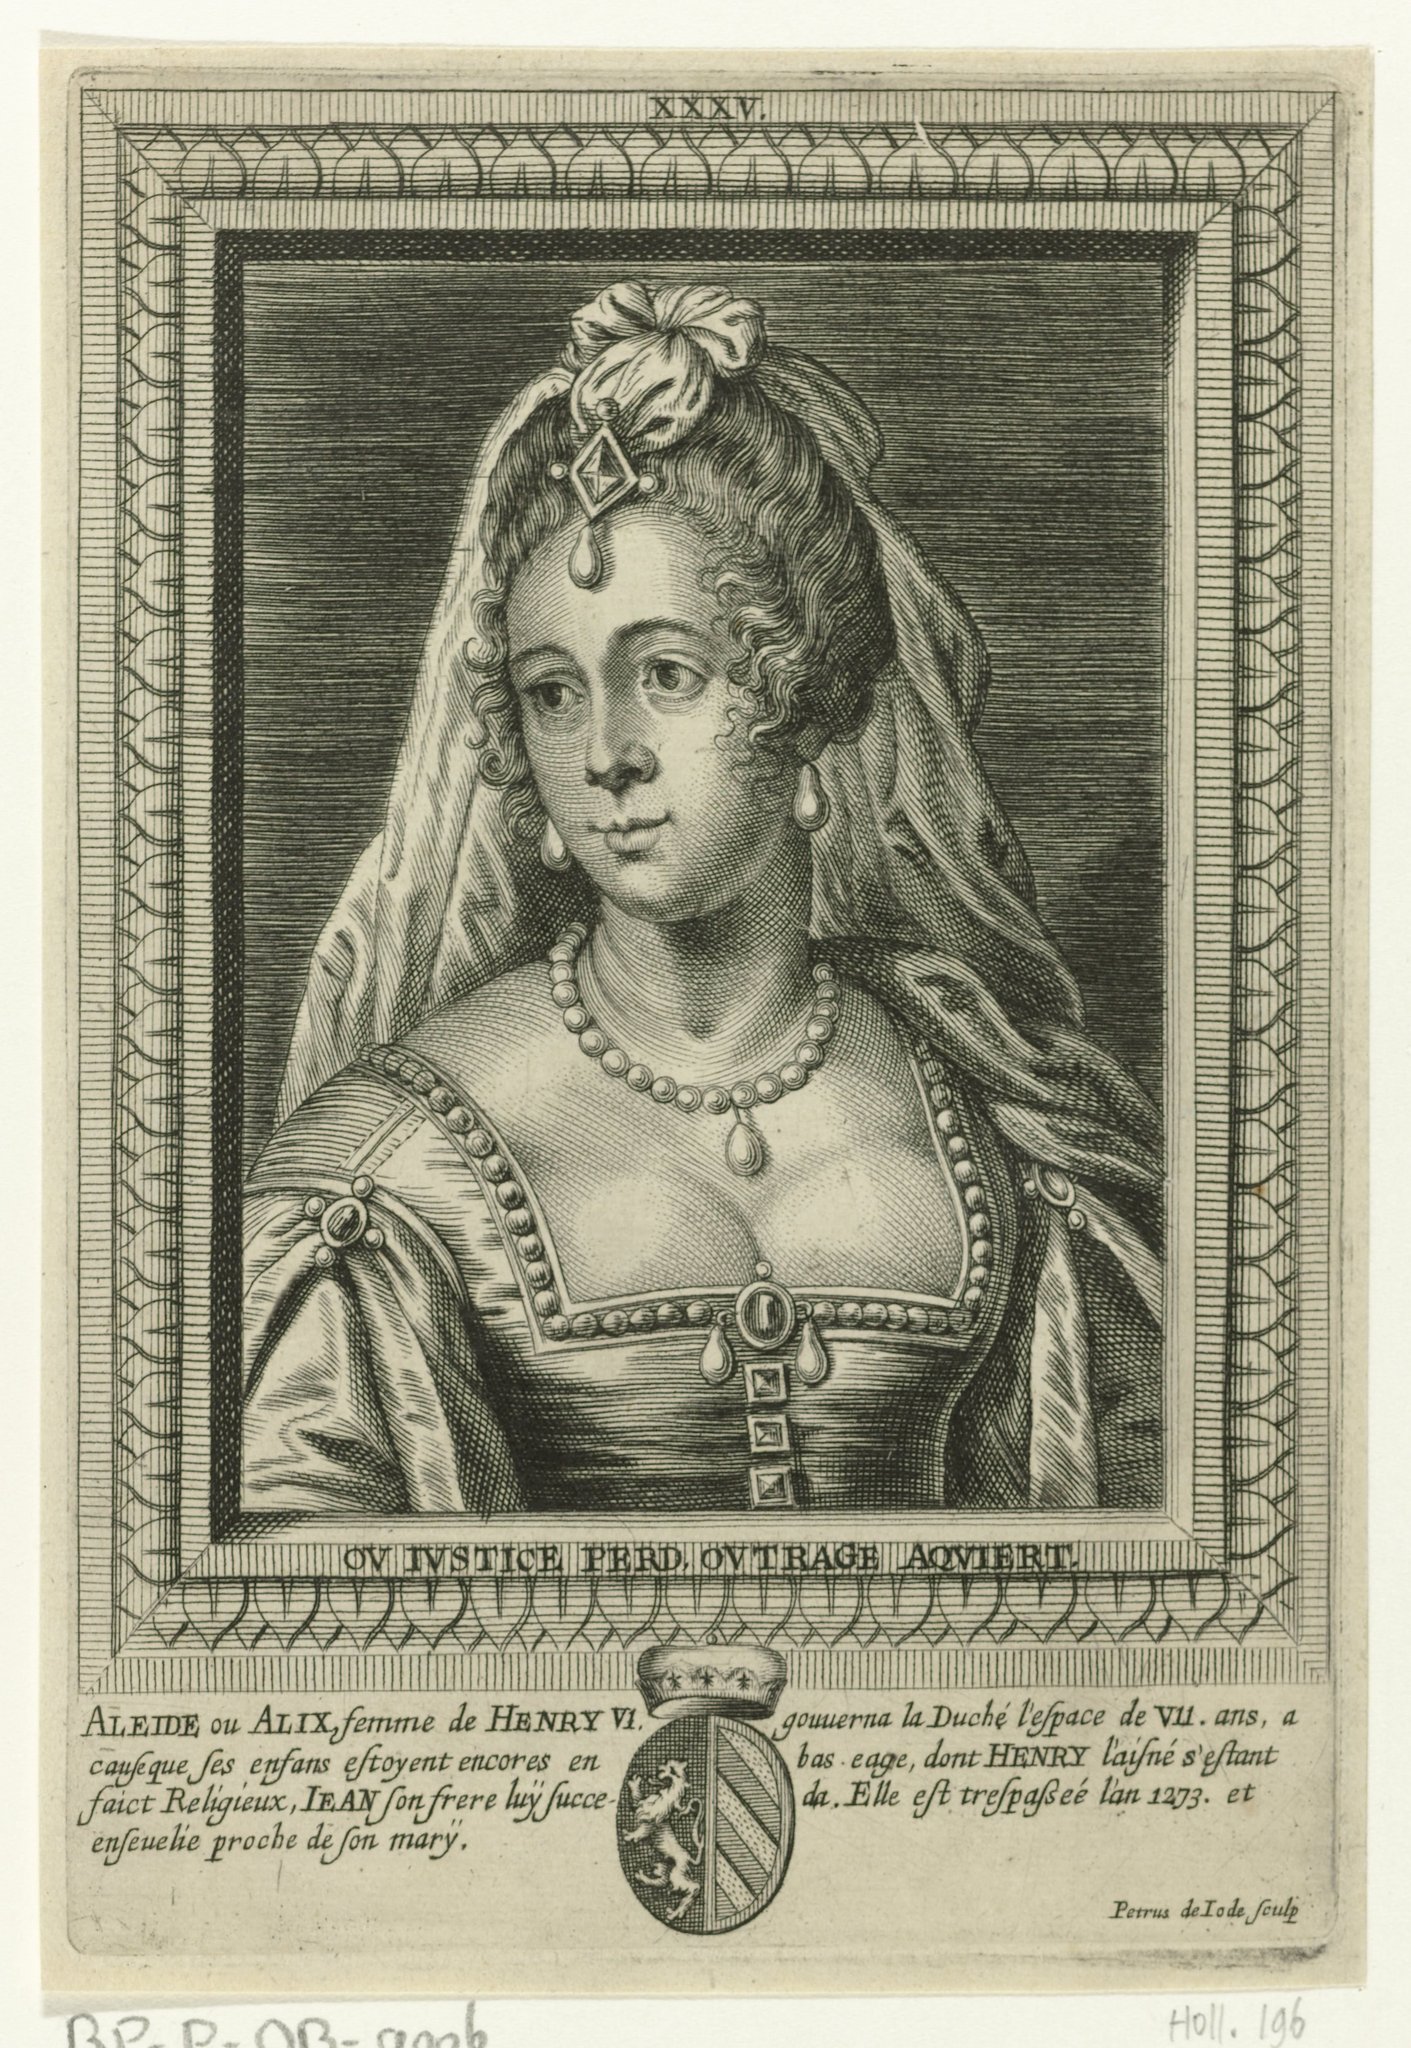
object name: print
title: Portret van Aleida, gemalin van Hendrik VI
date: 1661-1663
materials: paper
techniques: engraving, etching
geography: antwerp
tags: pearl; pearl necklace (+ women's clothes)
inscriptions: collector's mark: Lugt 2228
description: Busteportret van Aleida, met sluier. Ze draagt een parelketting en een jurk met laag uitgesneden decolleté. Het portret is gevat in een rechthoekige omlijsting met een motto in het Latijn. In de marge het wapenschild van de geportretteerde en een vierregelig onderschrift in het Frans. Prent uit een boek waarin 54 prenten met portretten.